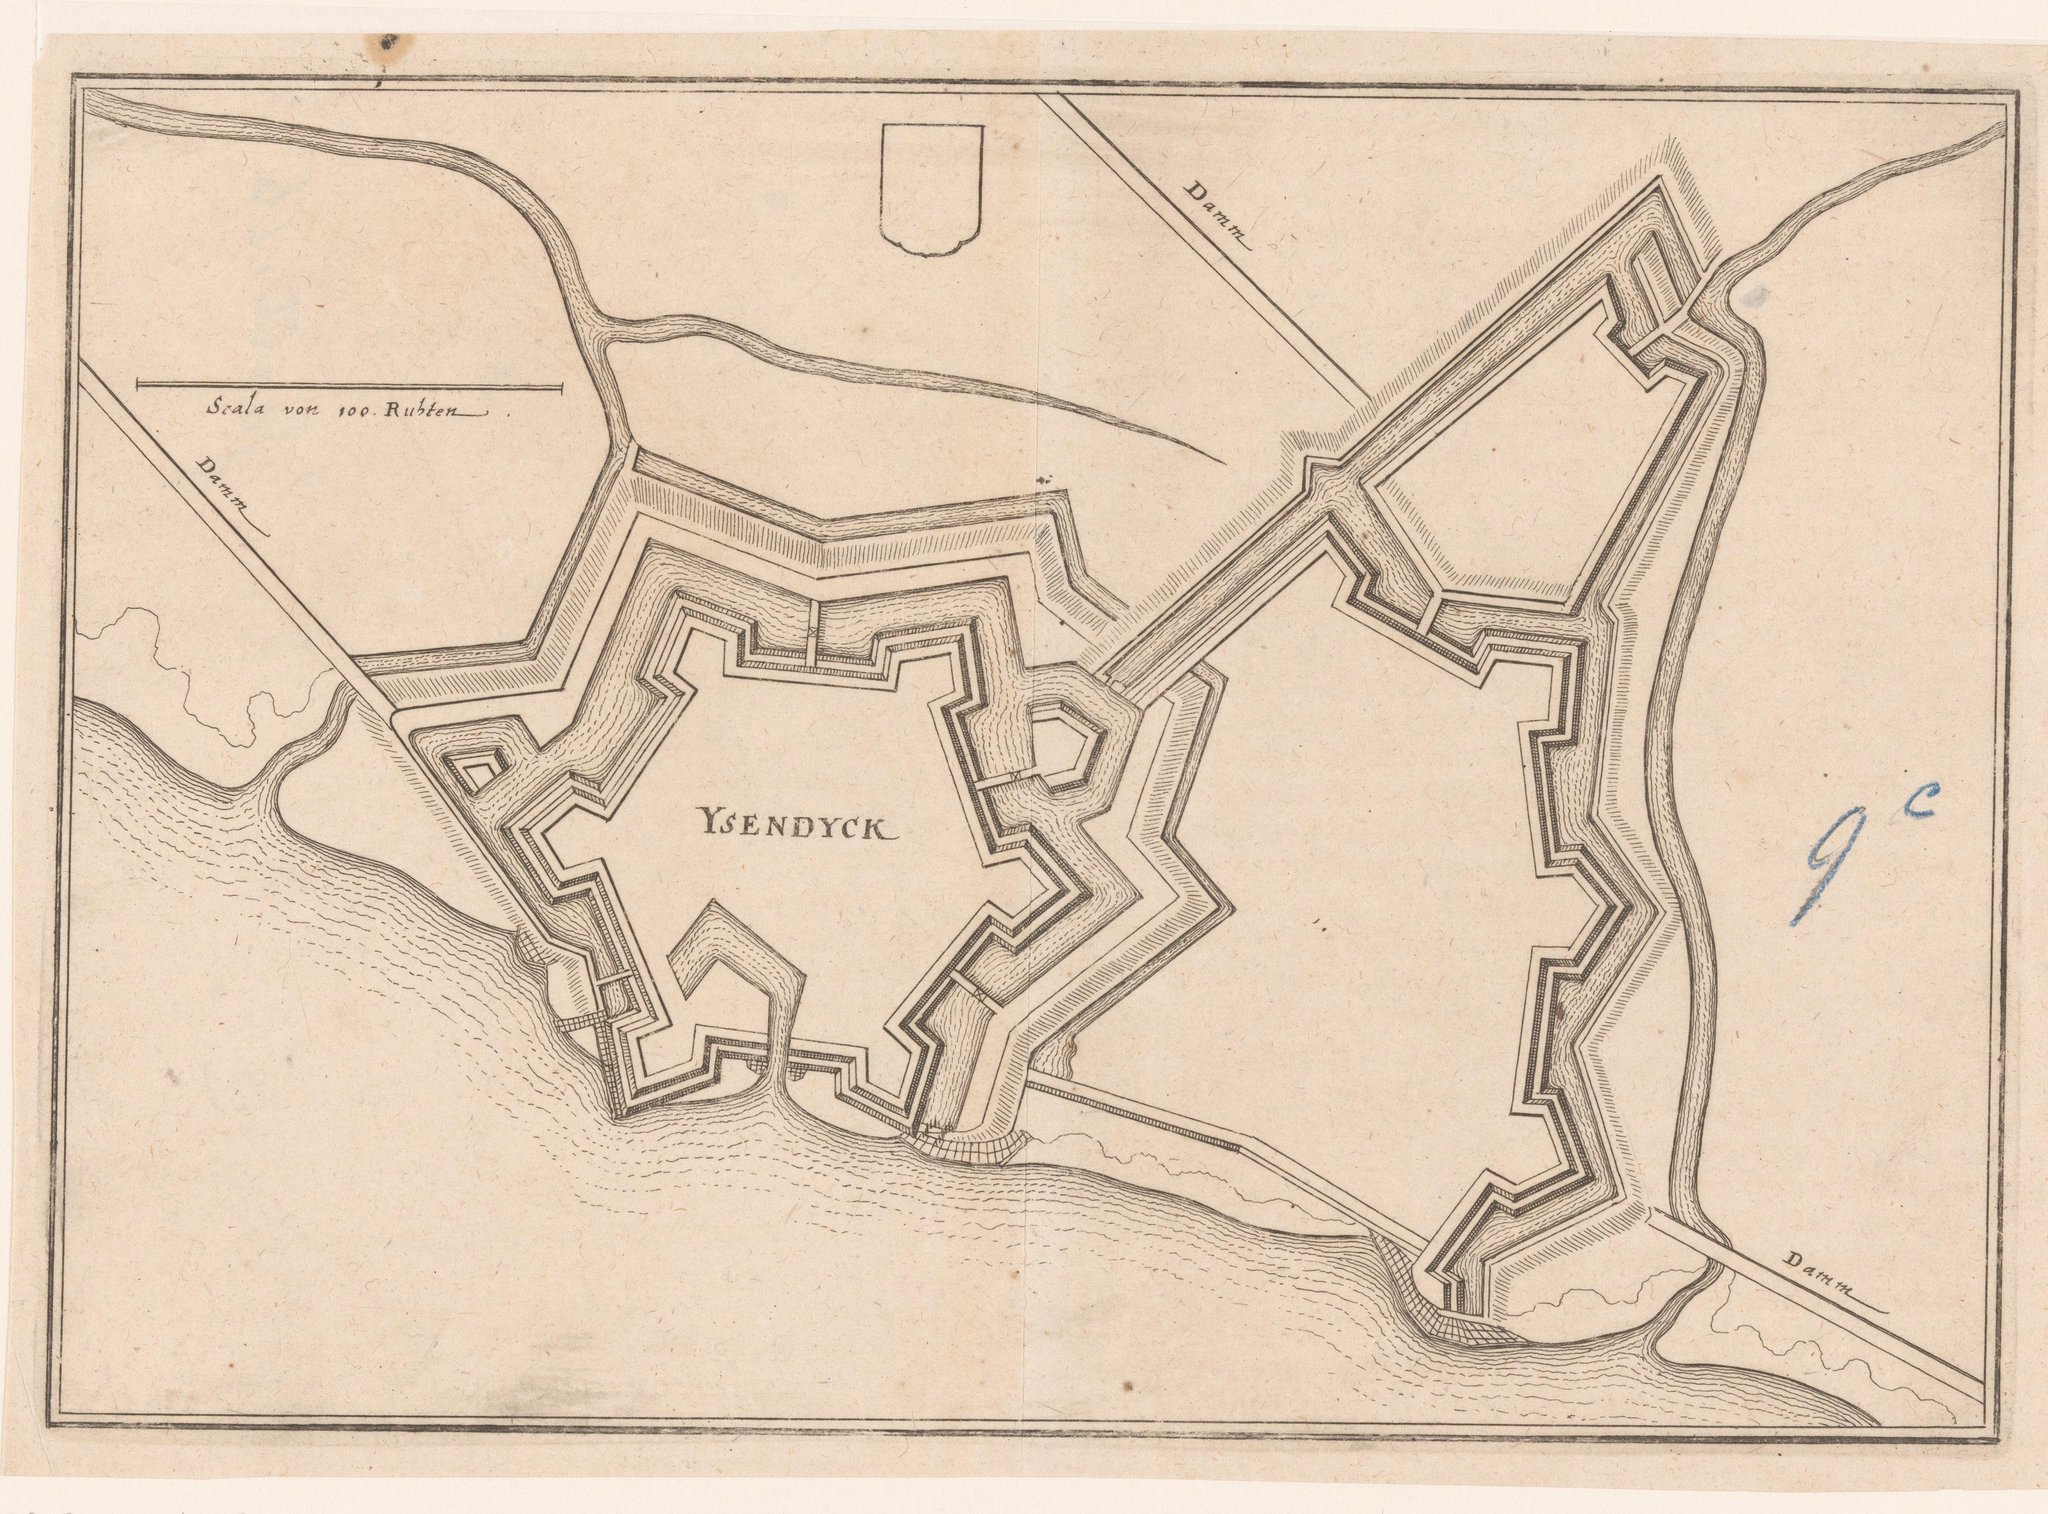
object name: print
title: Vestingplattegrond van IJzendijke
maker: caspar merian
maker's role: print maker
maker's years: 1627-1689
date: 1654-1700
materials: paper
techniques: etching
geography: frankfurt am main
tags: gate ~ fortified city, maps of cities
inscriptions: collector's mark: Lugt 2228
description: Prent gebruikt in: Zeiller, Martin. M.Z. Topographia Circuli Burgundici Oder Beschreibung une Eigentliche Abbildung der Vornehmsten Örter in dem Hochlöblichen Burgund- un Niderlandischen Crayse. Frankfurt am Main: Caspar Merian, 1654. Of in: Zeiller, Martin. M. Z. Topographia Germaniae-Inferioris vel Circuli-Burgundici, das ist Beschreibung (…). Frankfurt am Main: Caspar Merian, 1659. Of in een van de twee latere uitgaven van deze publicatie die, hoewel het jaar 1659 erin staat vermeld als jaar van uitgave, zijn uitgegeven in respectievelijk ca. 1670 en ca. 1700.